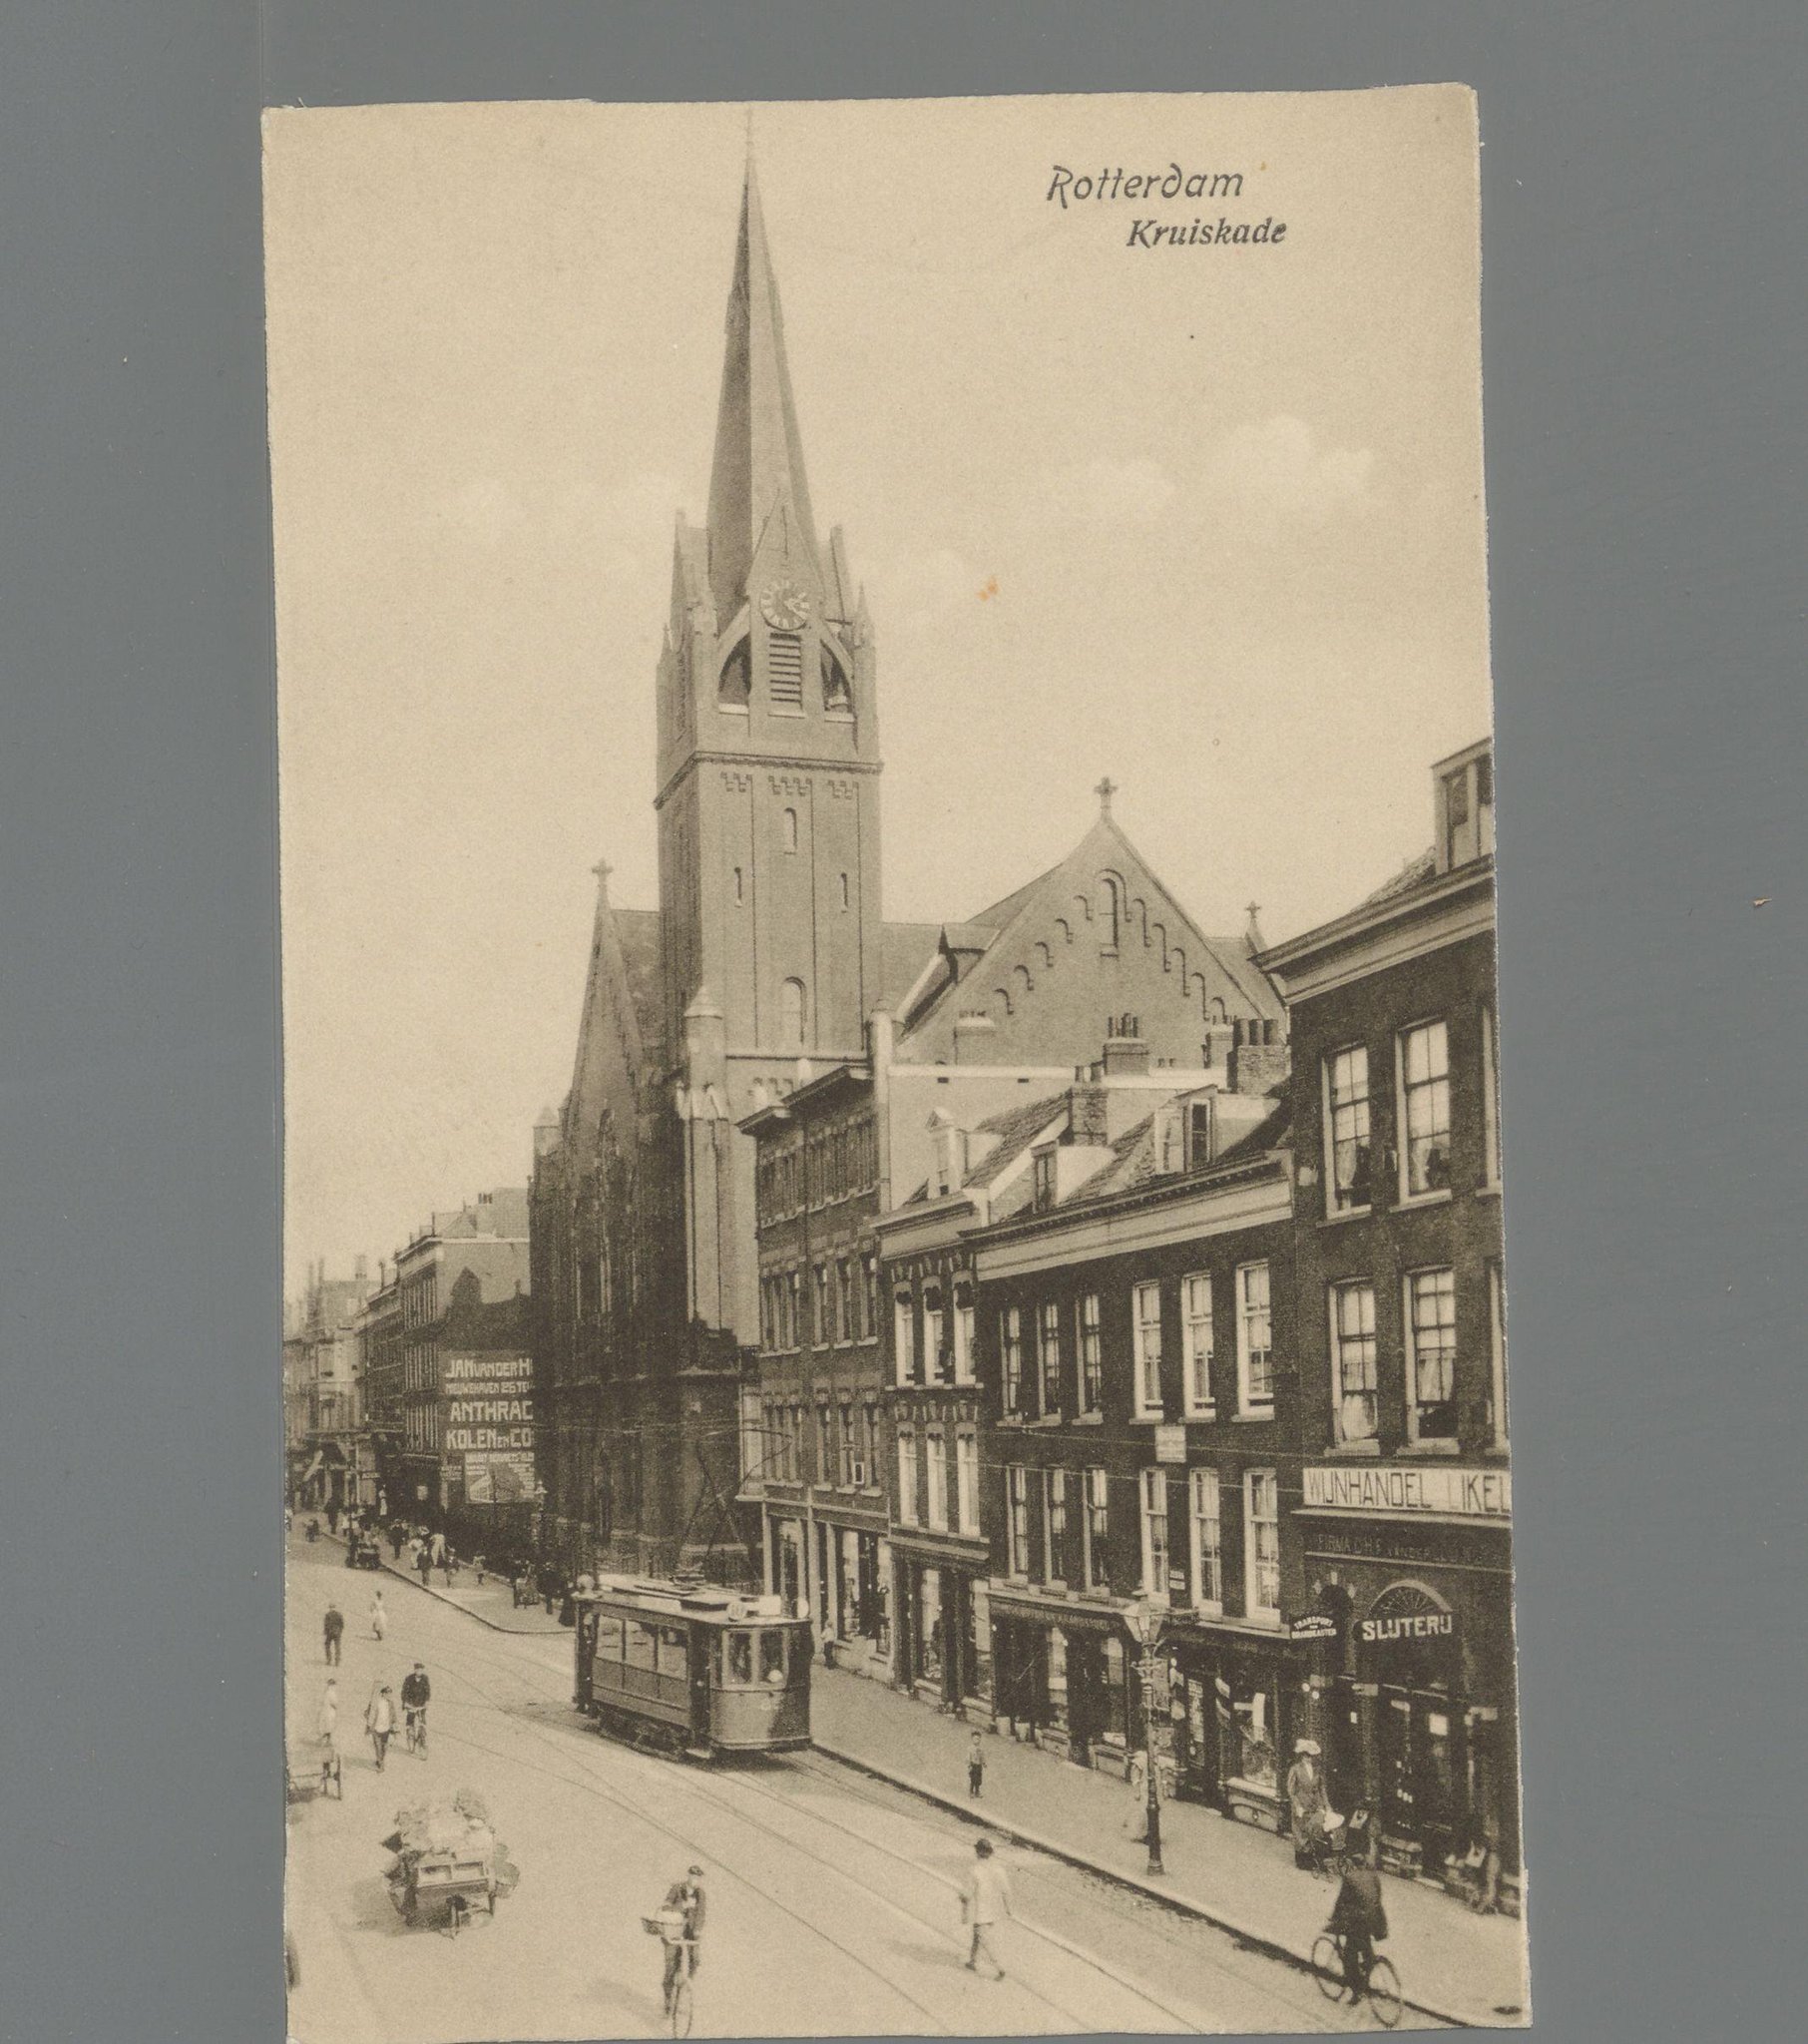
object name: photomechanical print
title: Rotterdam. Kruiskade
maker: Anonymous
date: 1912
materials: cardboard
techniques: photograph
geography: leipzig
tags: tram, church (exterior), street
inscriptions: date